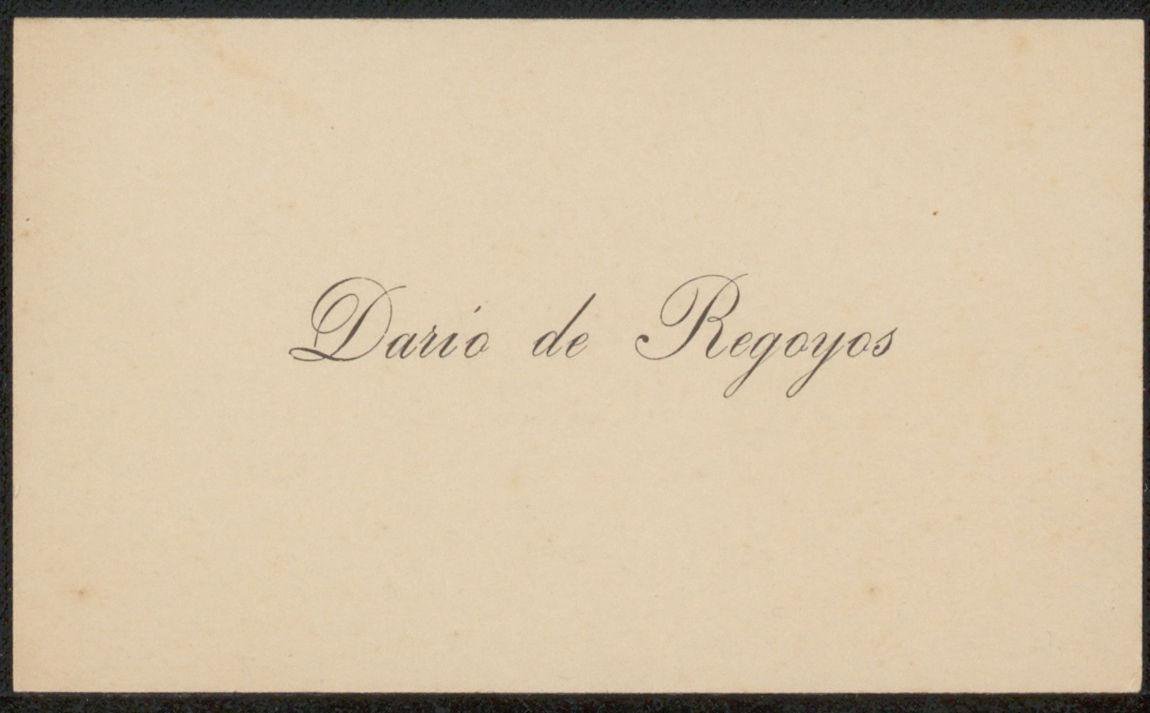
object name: visiting card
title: Visitekaartje aan Philip Zilcken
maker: darío de regoyos y valdés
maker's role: painter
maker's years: 1857-1913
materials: cardboard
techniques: printing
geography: donostia-san sebastián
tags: the hague, draughtsman, philip zilcken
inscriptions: collector's mark: ‘RPK’